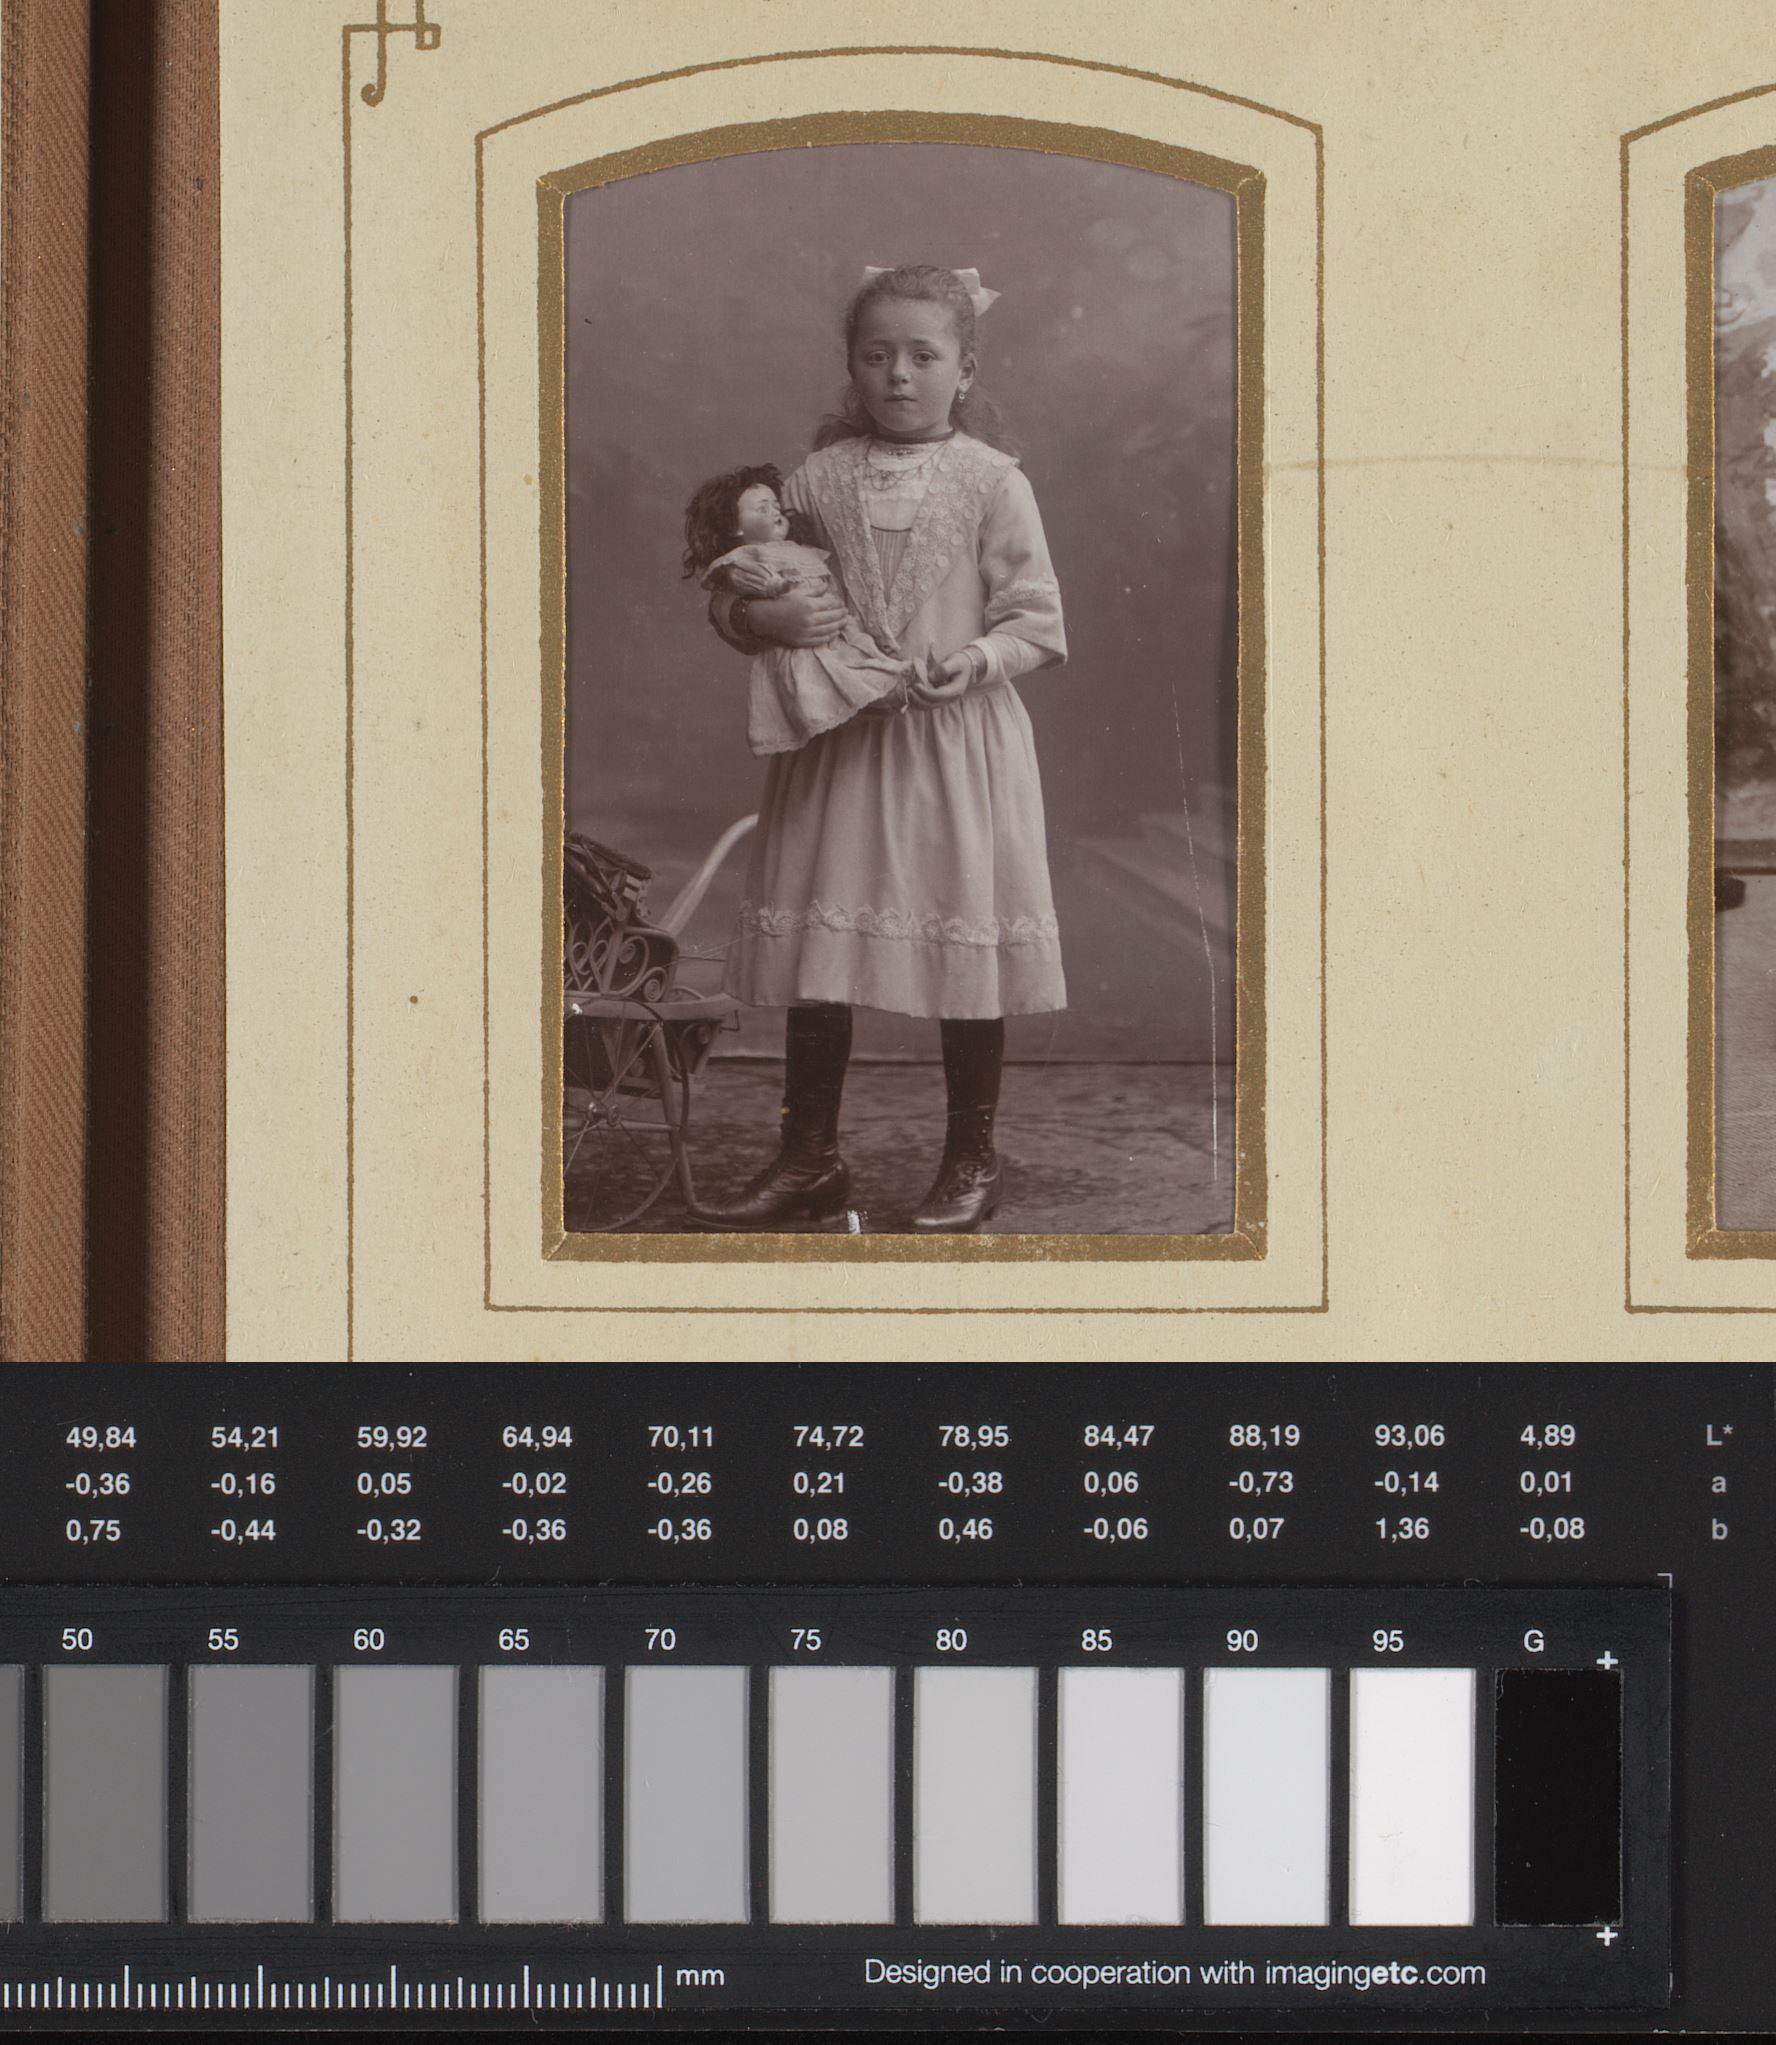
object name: carte de visite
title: Portret van een staand meisje met pop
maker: machiel hendricus laddé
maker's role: fotograaf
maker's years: 1866-1932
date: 1892-1906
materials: cardboard, photographic support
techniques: gelatin silver print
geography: amsterdam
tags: historical persons - bb - woman, girl (child between toddler and youth), (playing with) dolls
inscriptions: inscription: ‘M. H. Laddé/ Amsterdam,/ 57-59 Nieuwendijk.’